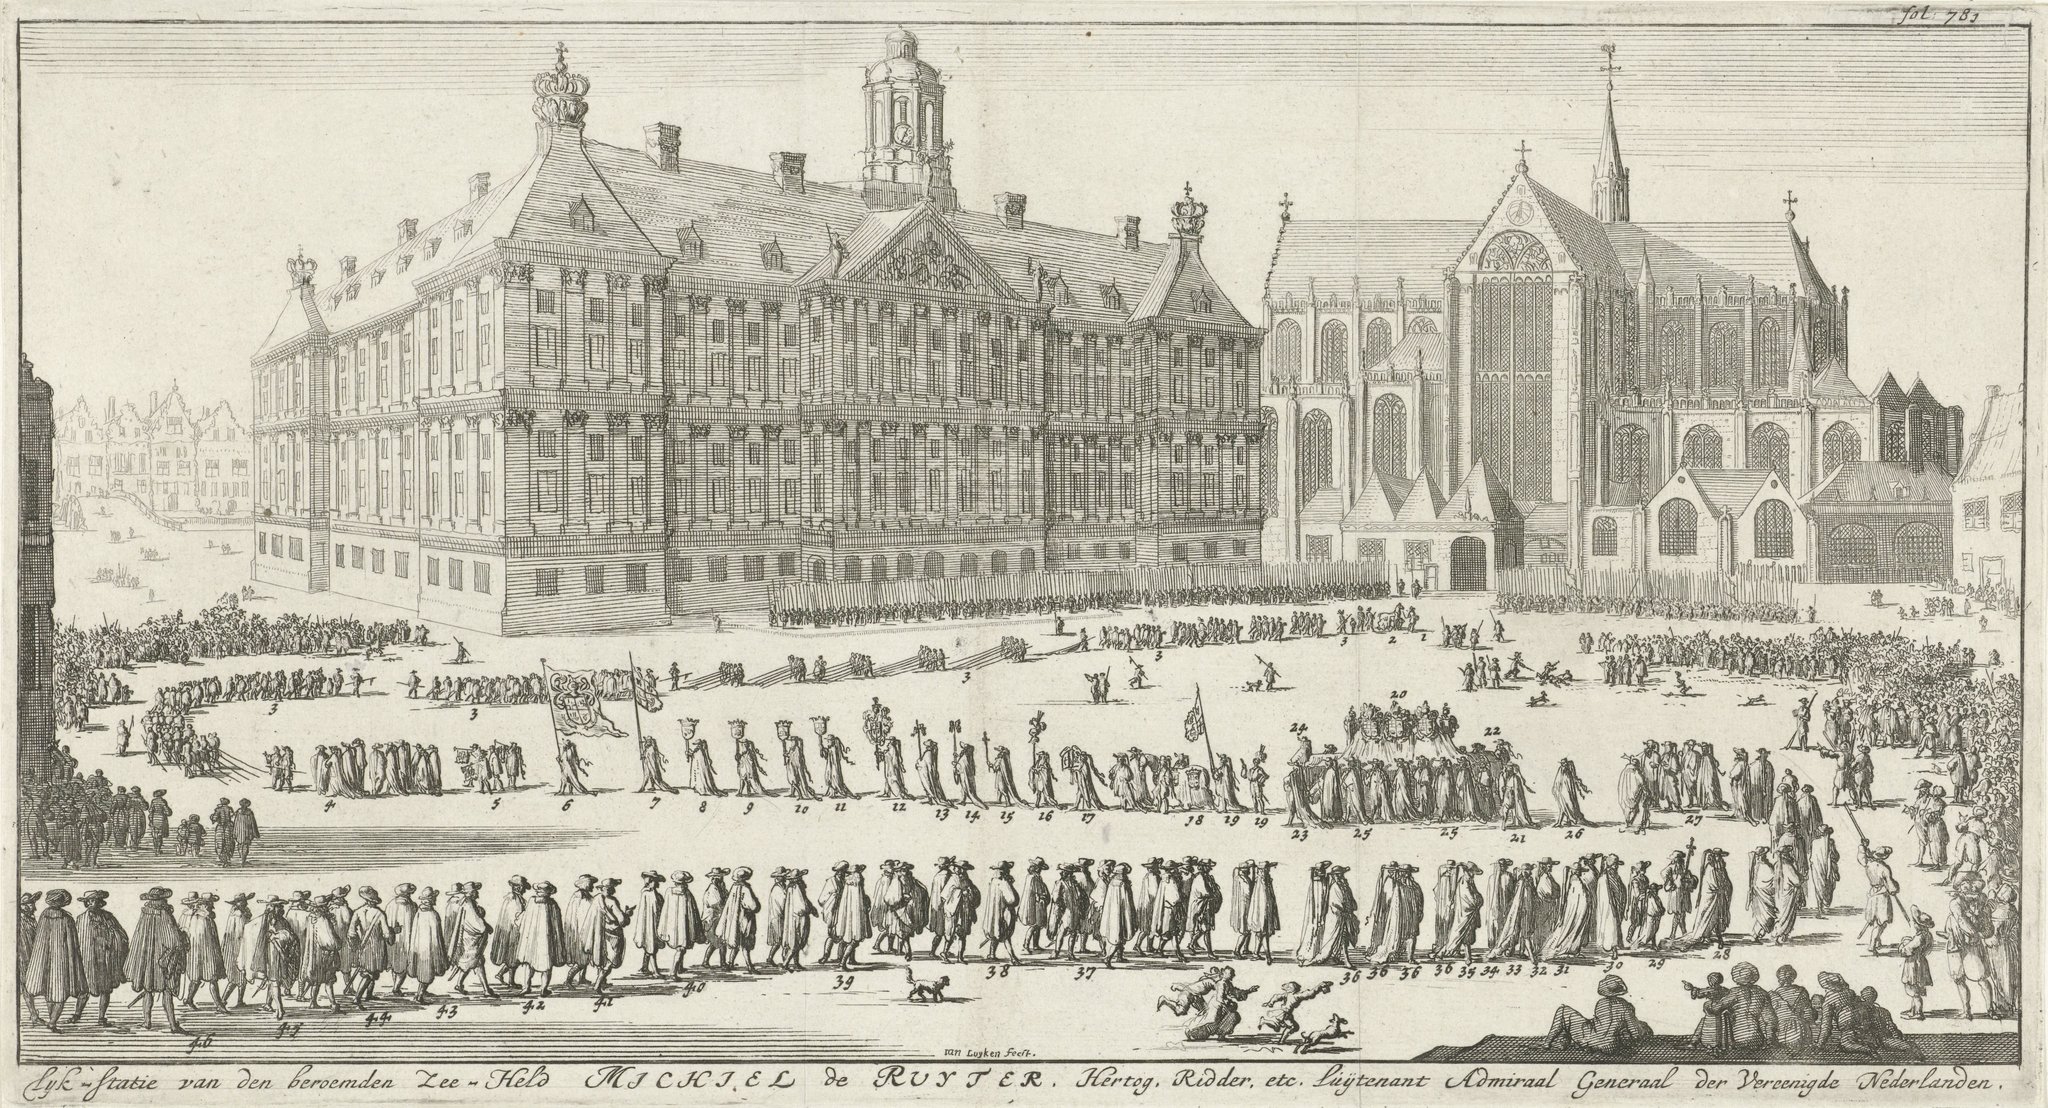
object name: book illustration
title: Lyk-statie van den beroemden Zee-Held Michiel de Ruyter, Hertog, Ridder etc. Luijtenant Admiraal Generaal der Vereenigde Nederlanden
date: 1683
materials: paper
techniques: engraving, etching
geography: amsterdam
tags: michiel adriaenszoon de ruyter, cortege, funeral procession, church (exterior), townhall, funerary ceremonial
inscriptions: collector's mark: Lugt 2228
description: Prent gebruikt in: Bosch, Lambert van den. Leeven en daaden der doorluchtigste zee-helden (…). Amsterdam: Jan Claesz ten Hoorn en Jan Bouman (I), 1683, p. 781. Latere staat van prent (RP-P-AO-23-17A) gebruikt in: Bosch, Lambert van den. Historien onses tyds, behelzende saken van staat en oorlogh, voorgevallen in, en omtrent de Vereenigde Nederlanden, en door geheel Europa (…). 3 delen. Amsterdam: Jan Claesz ten Hoorn en Jan Bouman (I), 1685-1699, dl. 1 (1685).